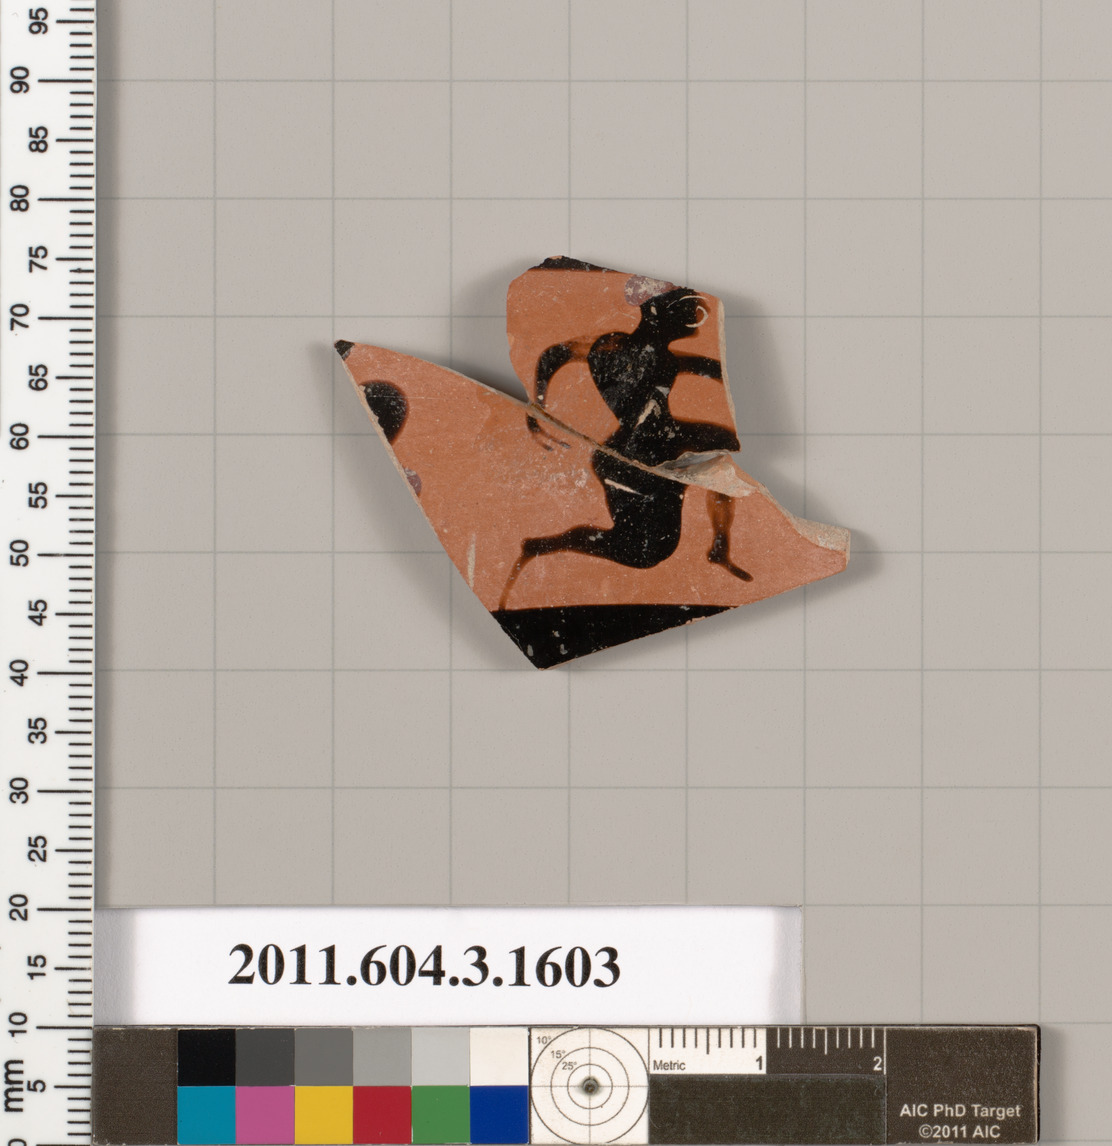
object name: kylix fragment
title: Terracotta fragment of a kylix: Band cup (drinking cup)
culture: greek, attic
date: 550-526 BCE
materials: terracotta